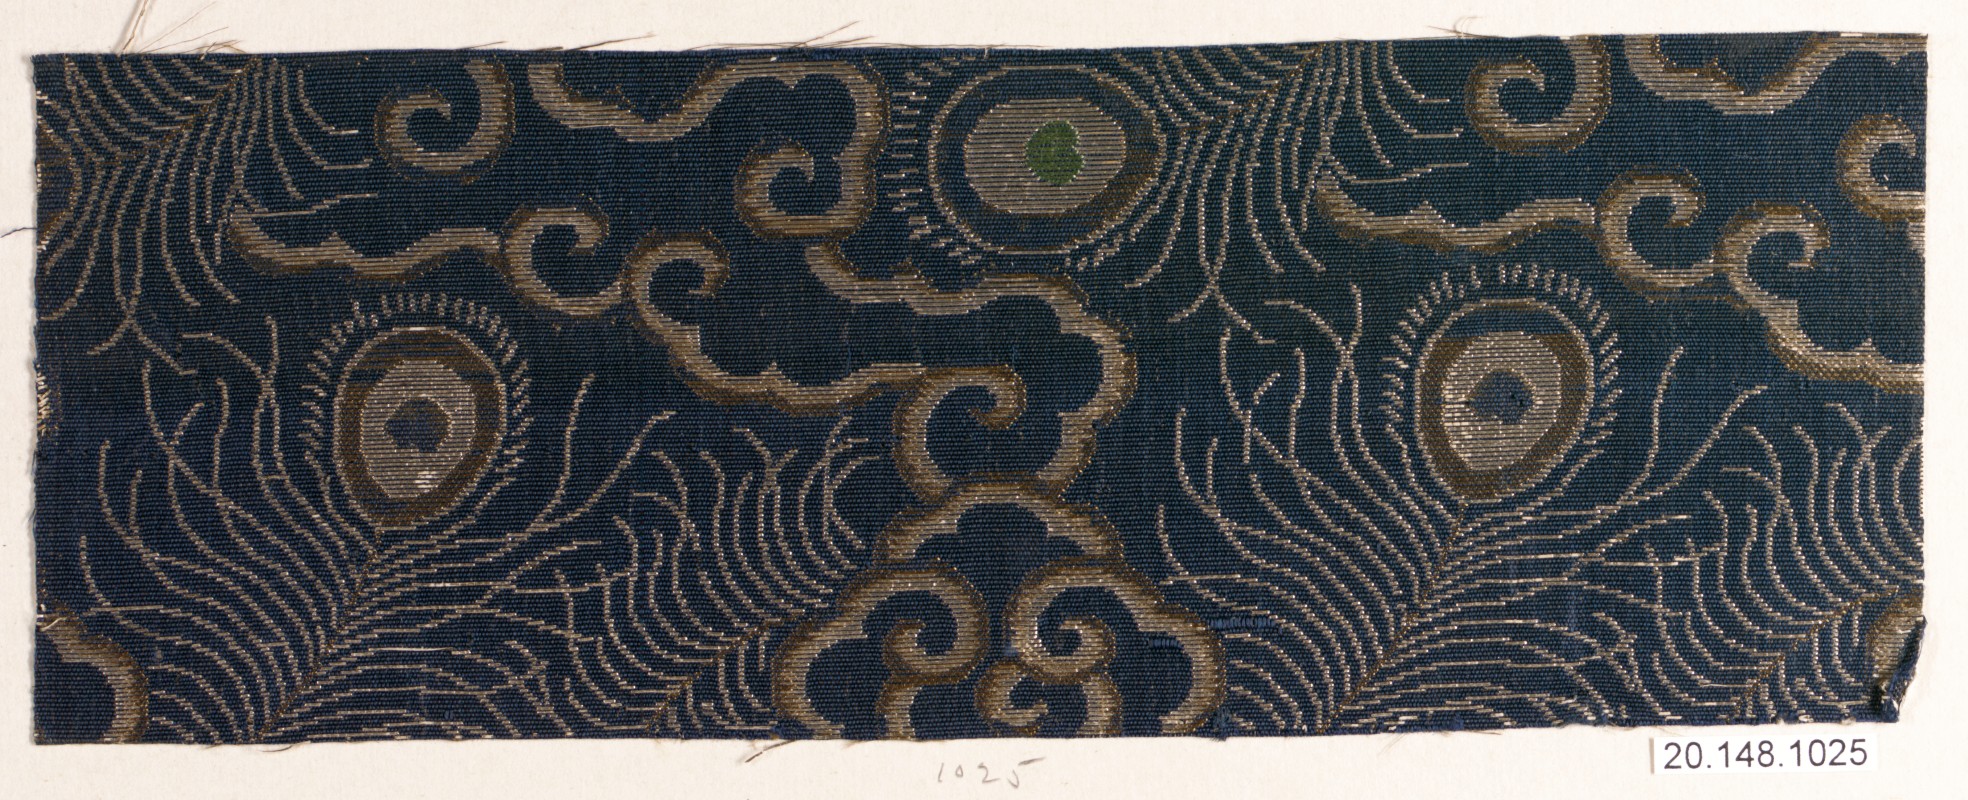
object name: piece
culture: japanese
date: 1701-1800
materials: silk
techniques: compound weave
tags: feathers